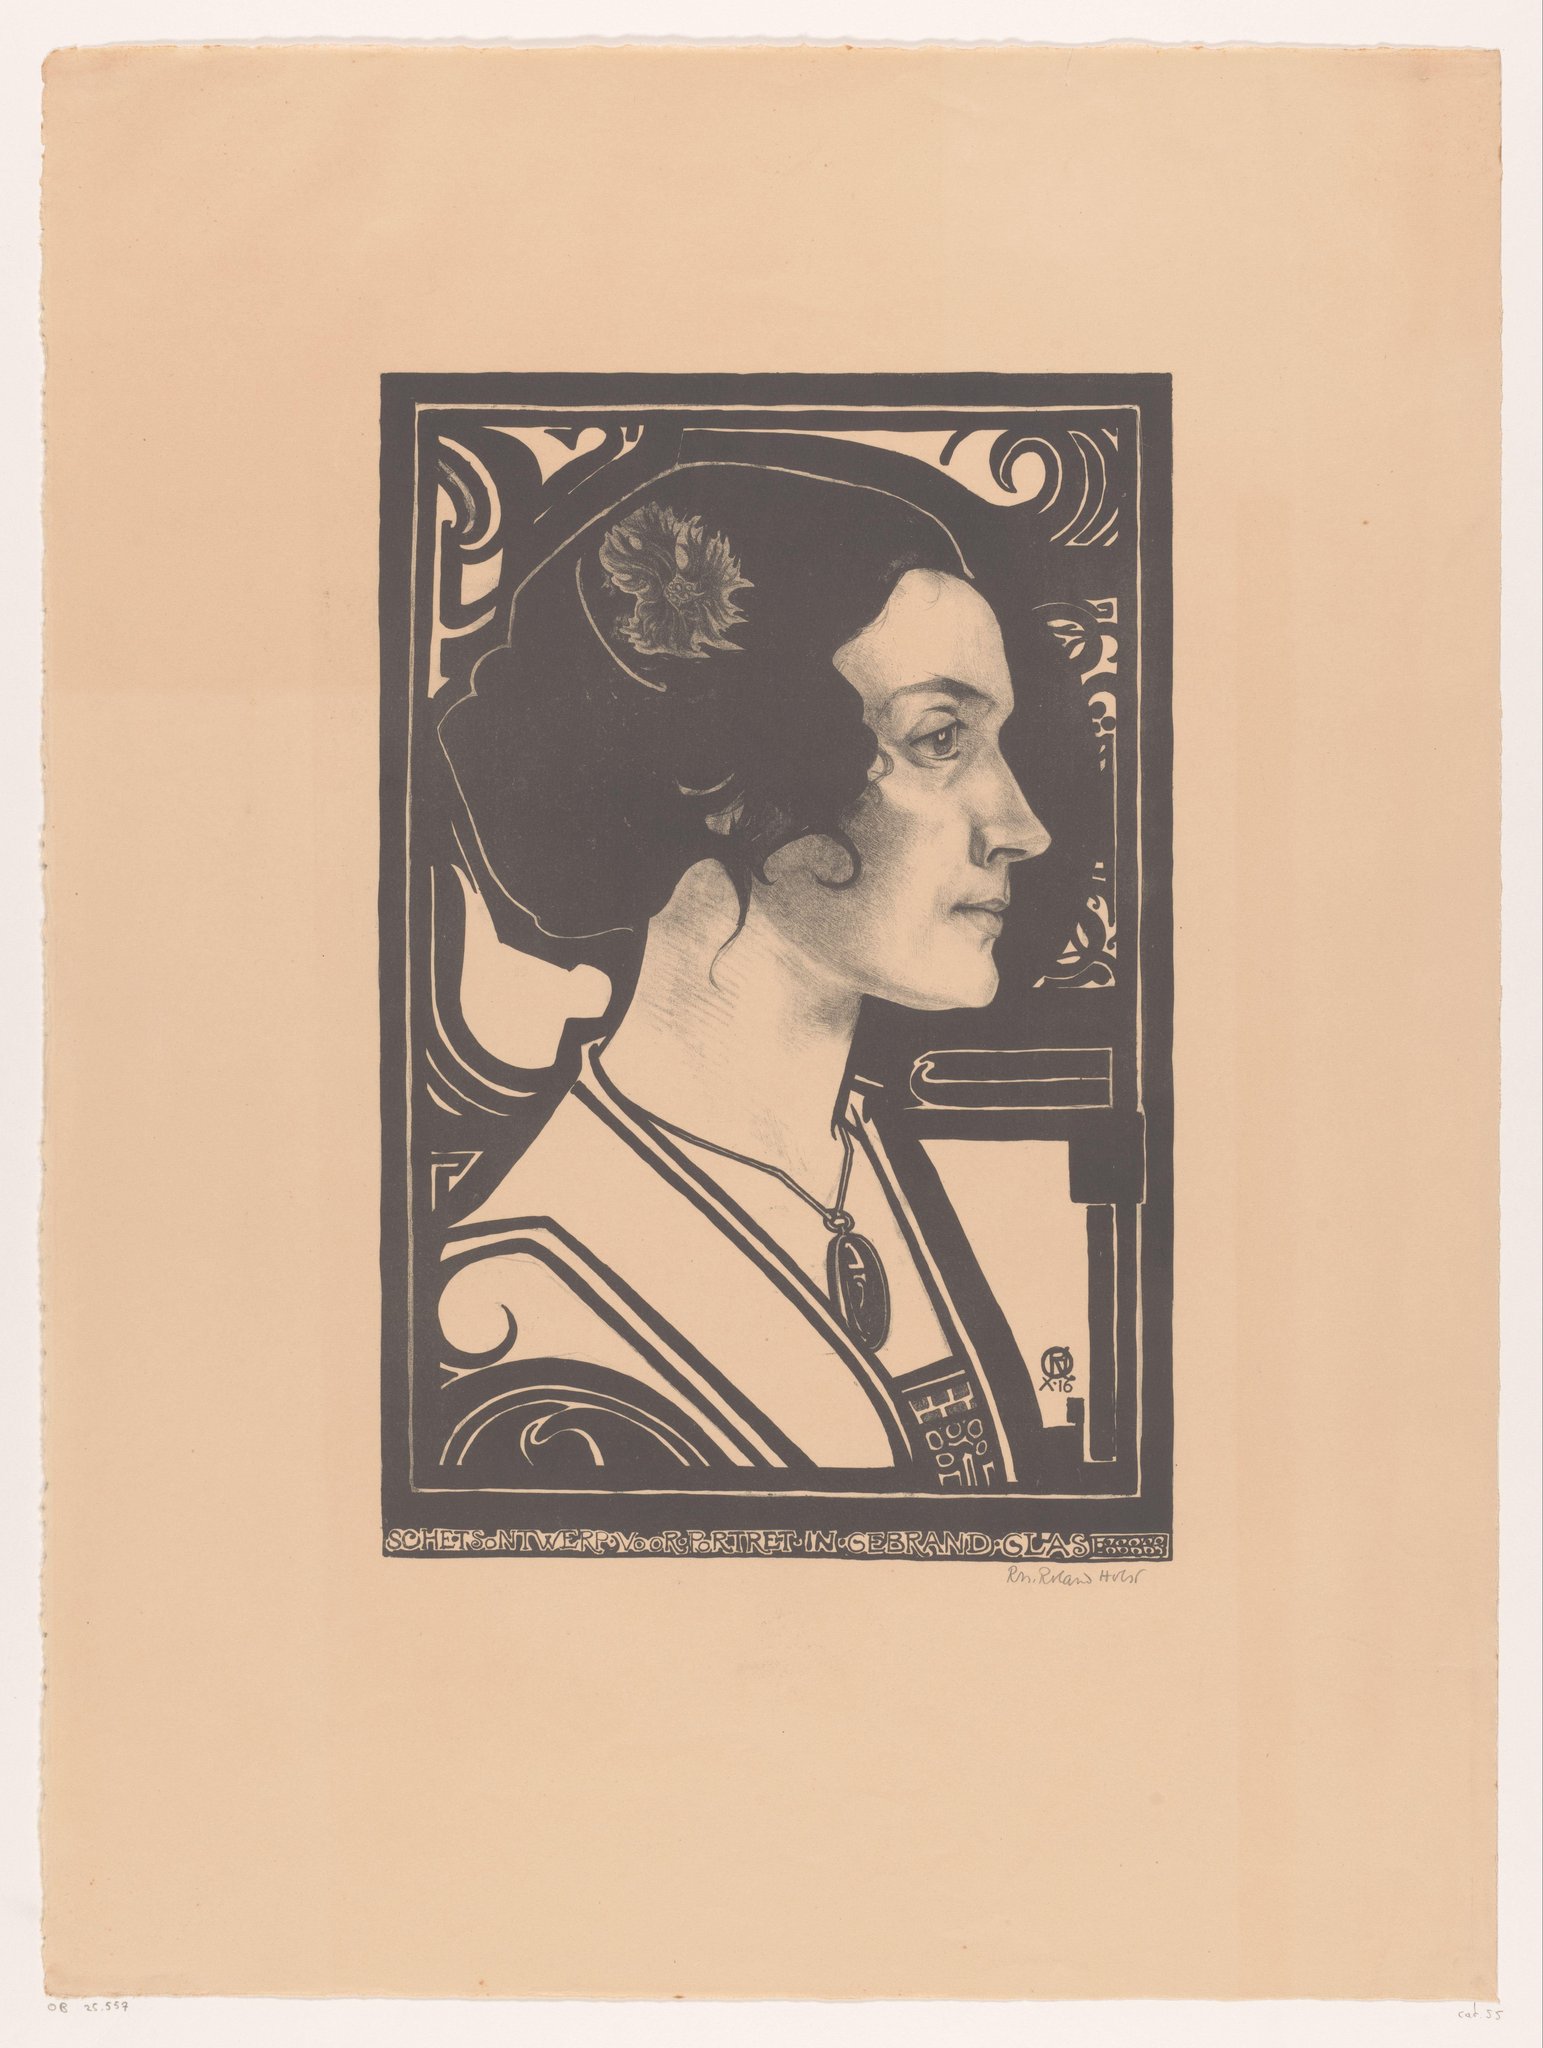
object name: design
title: Portret van een onbekende vrouw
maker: richard nicolaüs roland holst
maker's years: 1868-1938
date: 1910-1916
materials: paper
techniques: lithograph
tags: anonymous historical person portrayed - bb - woman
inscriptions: collector's mark: Lugt 2228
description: Een vrouw met opgestoken haar en een ketting.